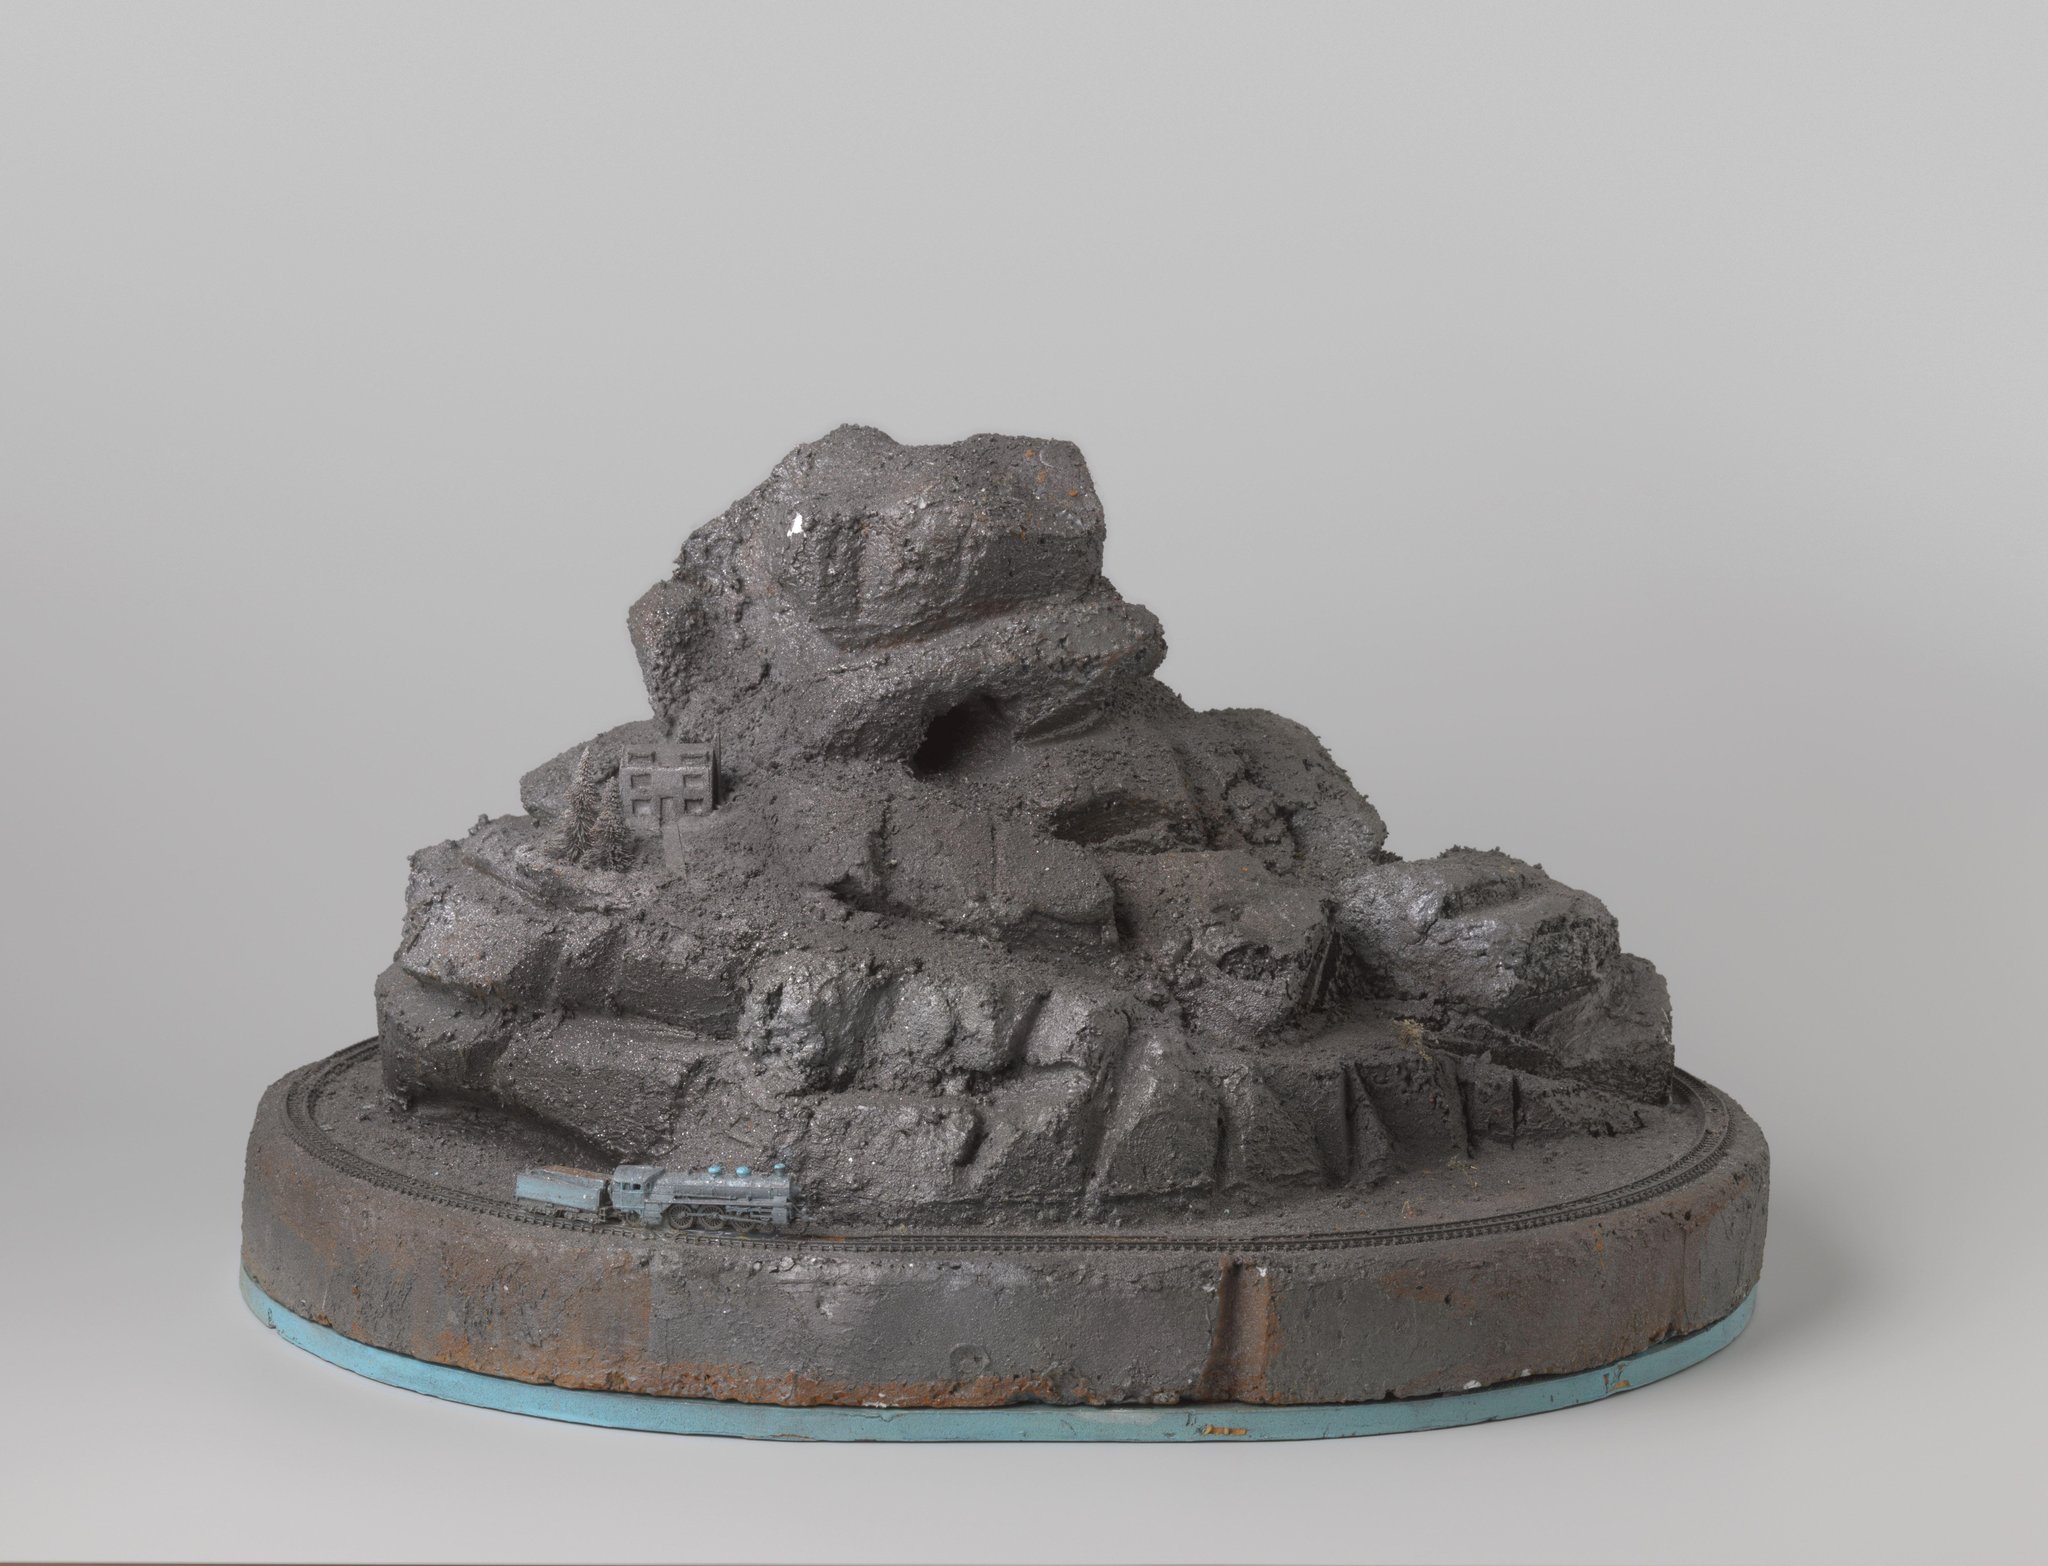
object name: model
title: My train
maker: hans op de beeck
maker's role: installatie-kunstenaar, videokunstenaar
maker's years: 1969-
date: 2002-2003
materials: plastic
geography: netherlands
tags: netherlands, france, belgium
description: Draagbaar model of schets van een spoorlandschap geïnspireerd op de Hoge Snelheidslijn van Amsterdam naar Parijs. Rond een rotspartij rijdt een trein in eindeloze rondjes. Het geheel wordt afgedekt door een zilverkleurige "Beautycase" van aluminium (NG-2008-28-9-1). Met opschrift. Gemaakt in opdracht van Atelier HSL.